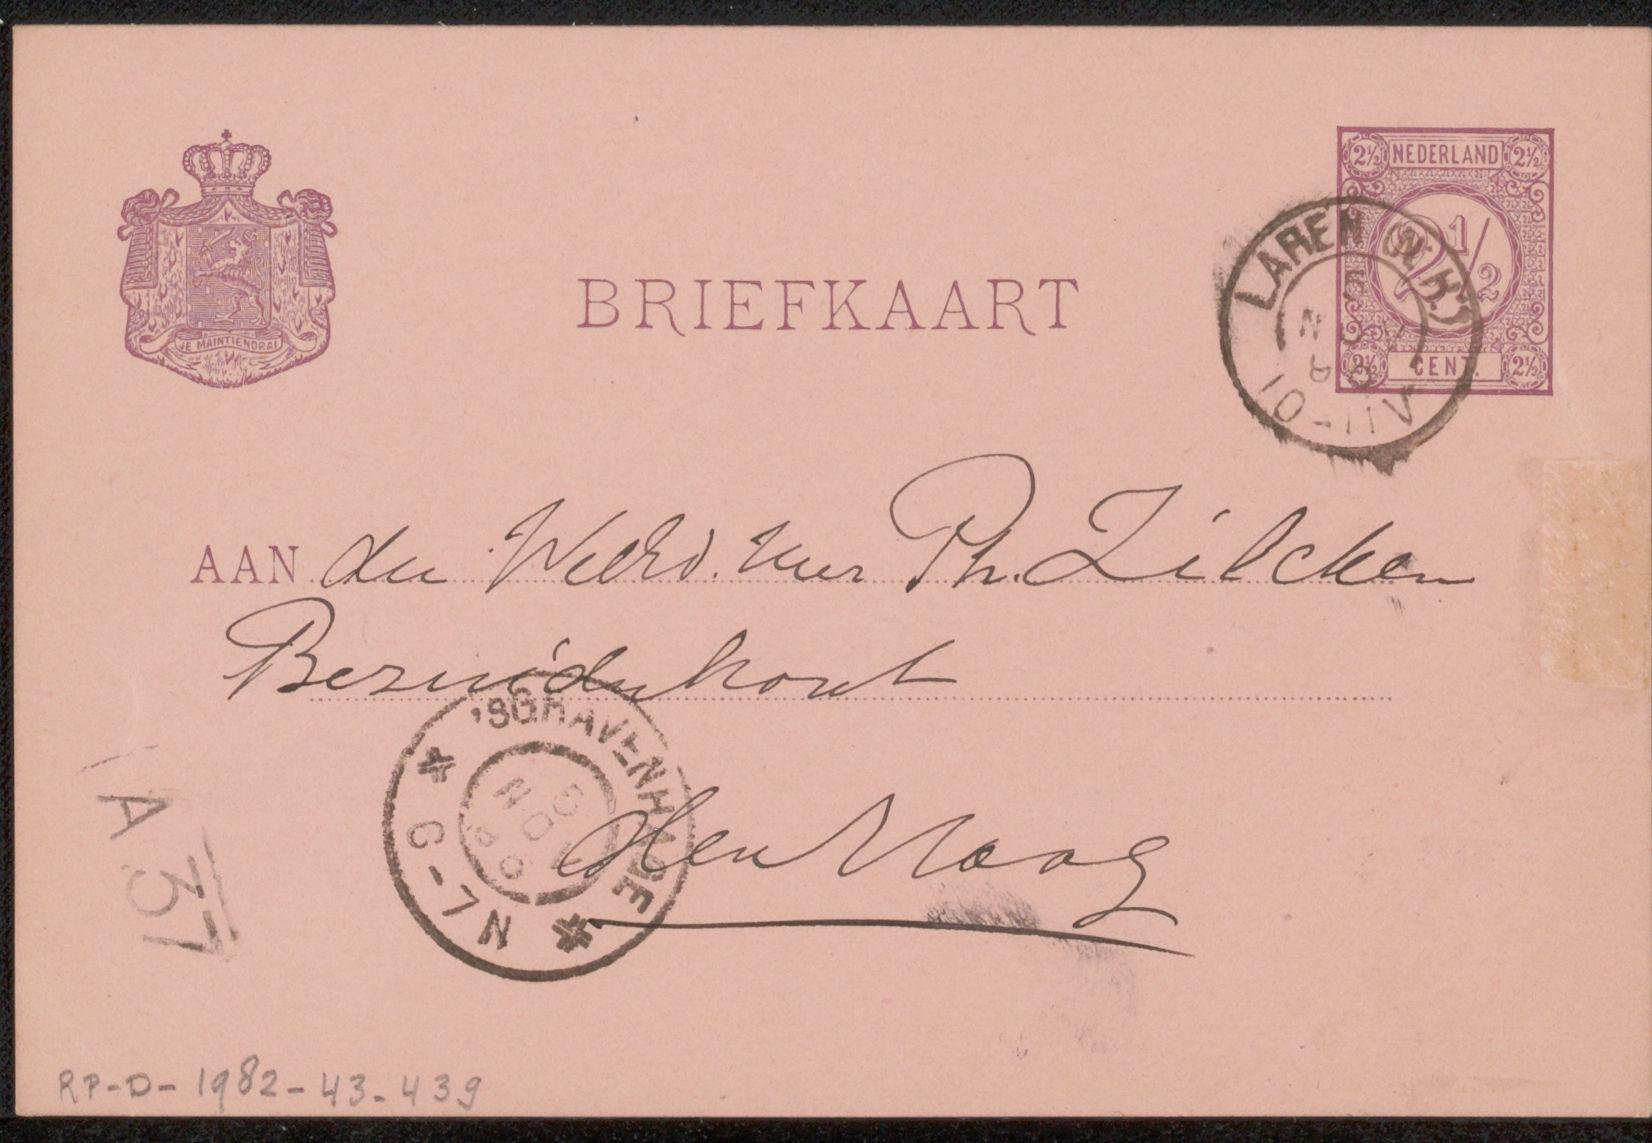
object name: postcard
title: Briefkaart aan Philip Zilcken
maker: albert neuhuys (1844-1914)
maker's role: draughtsman, painter, print maker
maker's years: 1844-1914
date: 1895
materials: cardboard, ink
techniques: pen, writing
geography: laren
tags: brussels, helène lambertine hauzeur, philip zilcken, passions, emotions, affections